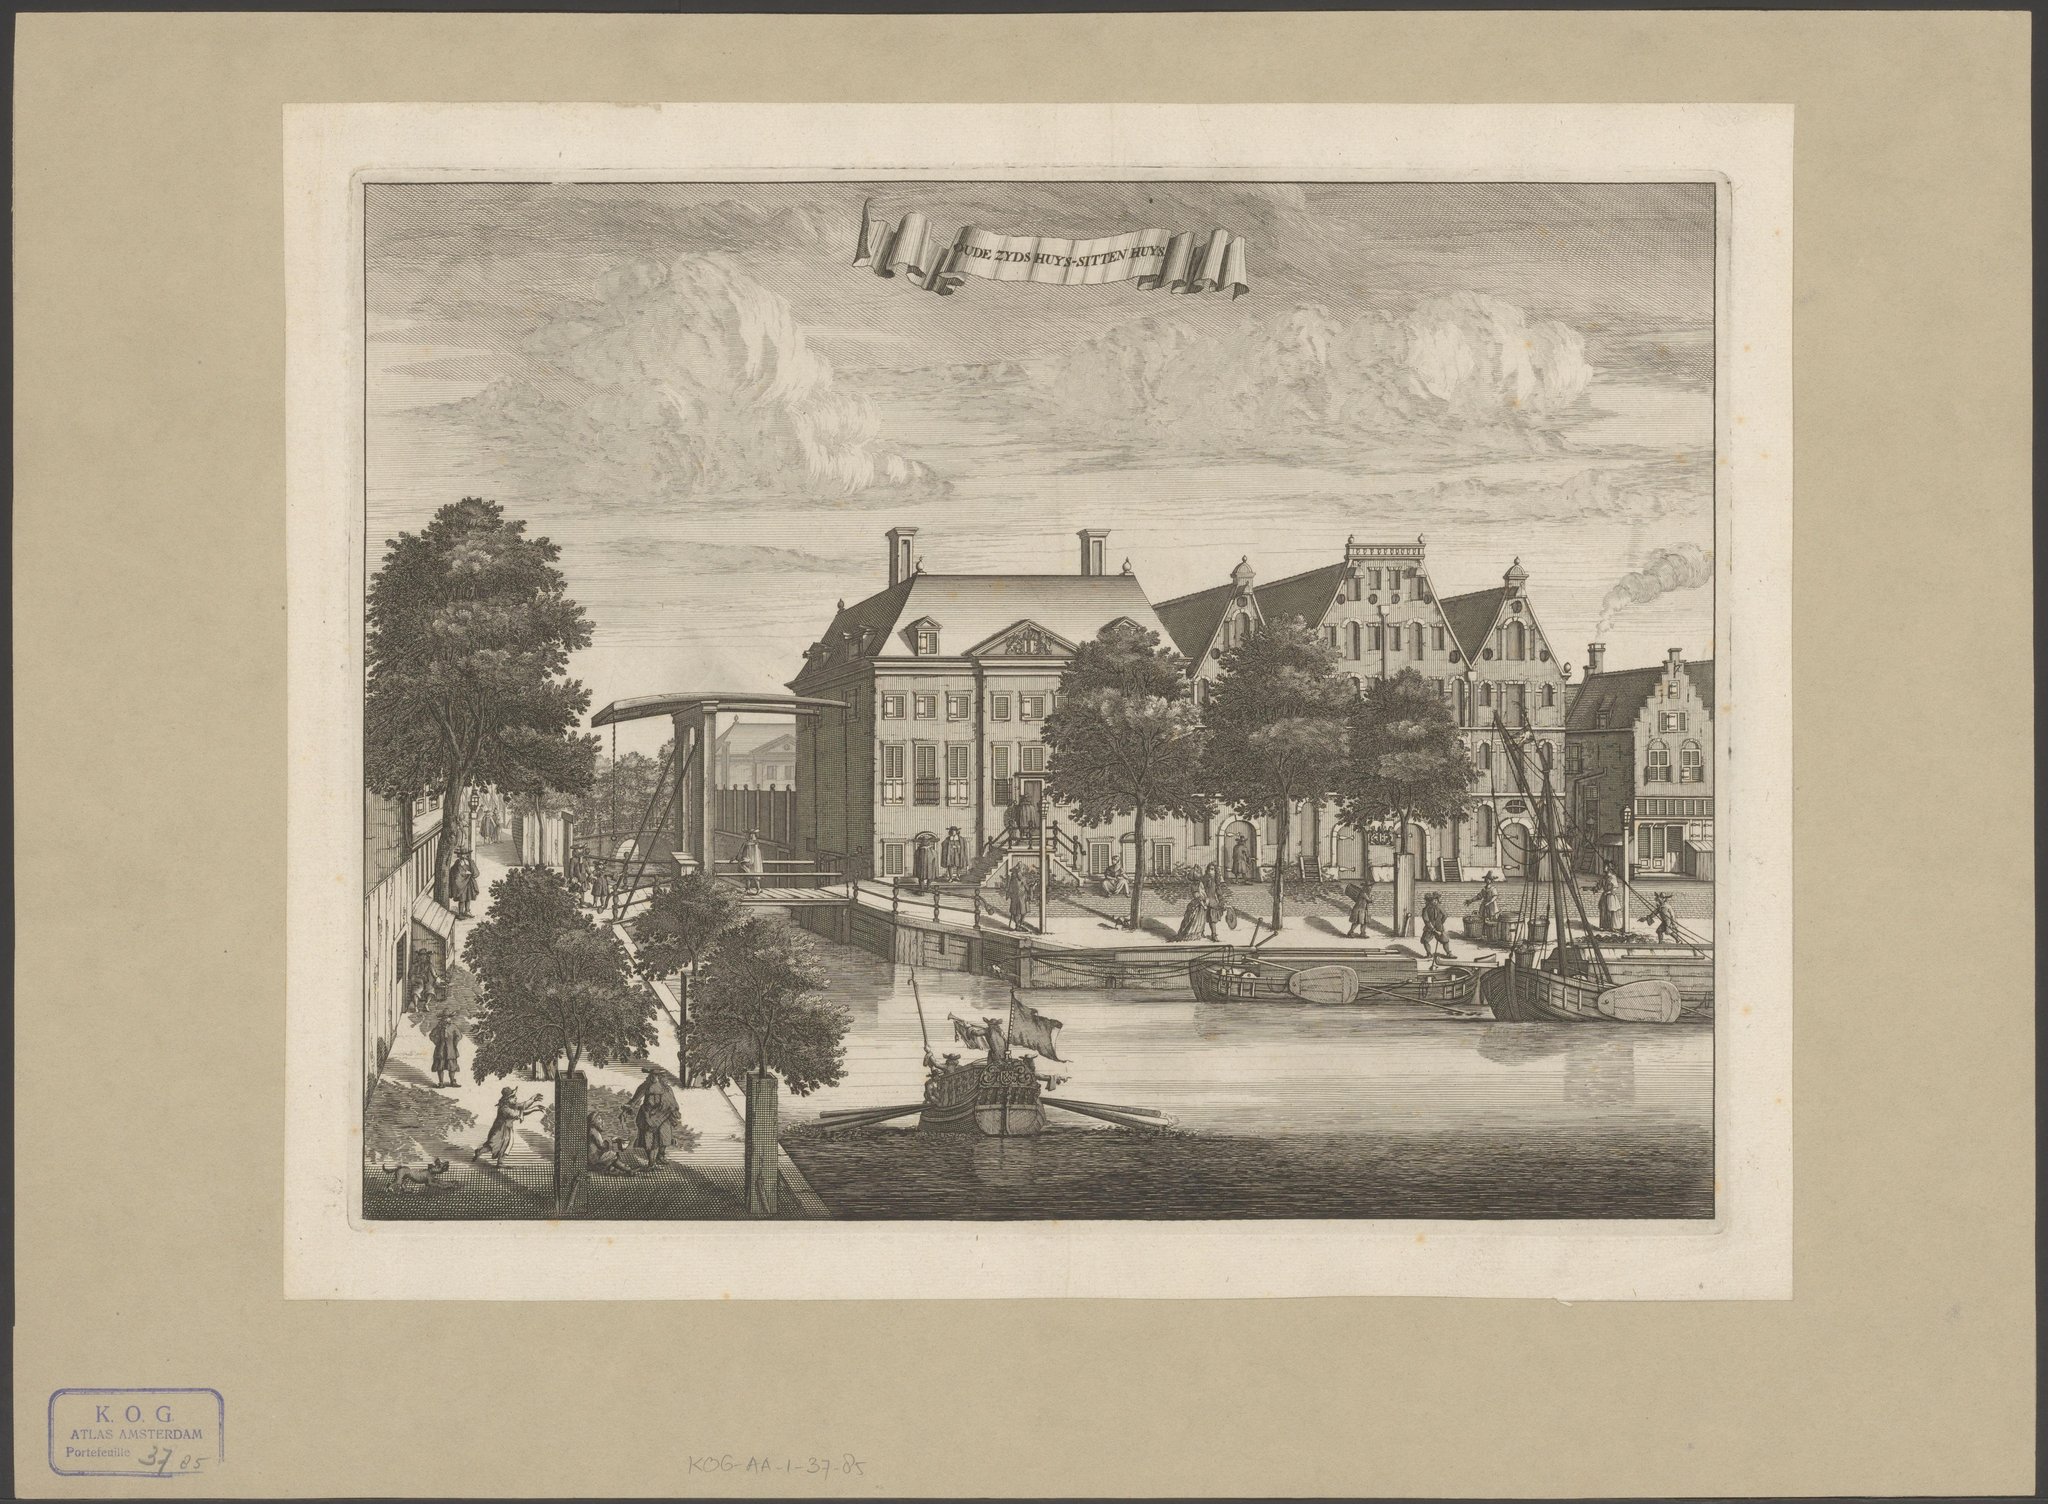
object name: print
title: Gezicht op het Oudezijds Huiszittenhuis te Amsterdam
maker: Anonymous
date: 1726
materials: paper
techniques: engraving, etching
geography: northern netherlands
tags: poorhouse, ships (in general), beggar, canals, waters (in city) (+ city(-scape) with figures, staffage)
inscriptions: collector's mark: Lugt 1641b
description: Huidige staat van prent ook gebruikt in: Commelin, Casparus. Beschryvinge van Amsterdam (…). 2de druk. Amsterdam: Andries van Damme, Johannes Ratelband, weduwe Antony van Aeltwijk en Hermanus Uytwerf, 1726, dl. 2. Eerste staat van prent (zonder opgewerkte lucht- en waterpartijen) ook gebruikt in: Commelin, Casparus. Beschryvinge van Amsterdam (…). Amsterdam: Abraham Wolfgang, Gillis Janssonius van Waesberge of Johannes Janssonius van Waesberge, Hendrick Boom of weduwe Dirk Boom, Abraham van Sanderen en Rembertus Goethals, 1693, dl. 2. En in: Commelin, Casparus. Beschryvinge van Amsterdam (…). Amsterdam: weduwe Aart Dircksz. Oossaan, 1694, dl. 2.